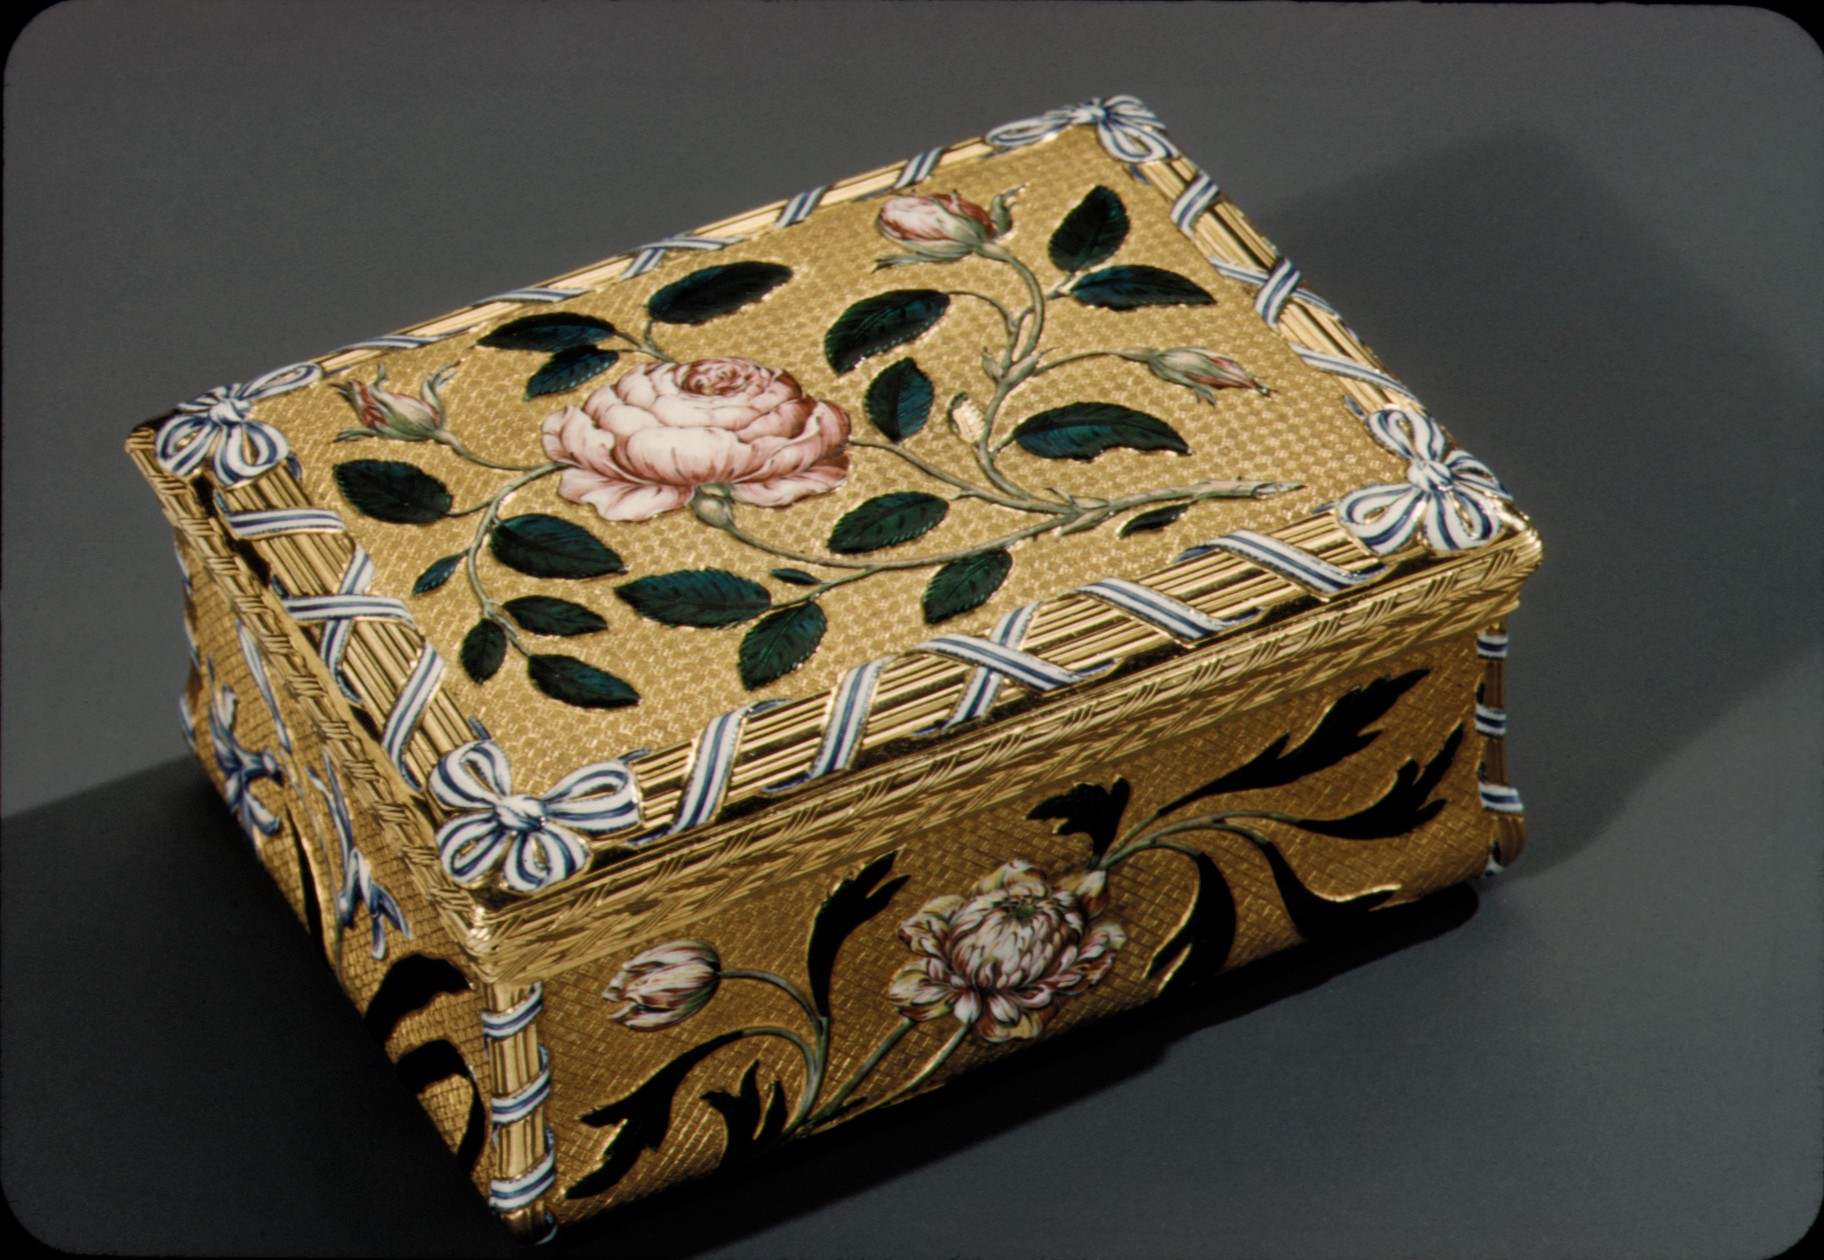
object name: snuffbox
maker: jean moynat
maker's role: maker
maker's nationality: french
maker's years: 1661-1761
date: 1747-1749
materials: enamel, gold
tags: roses